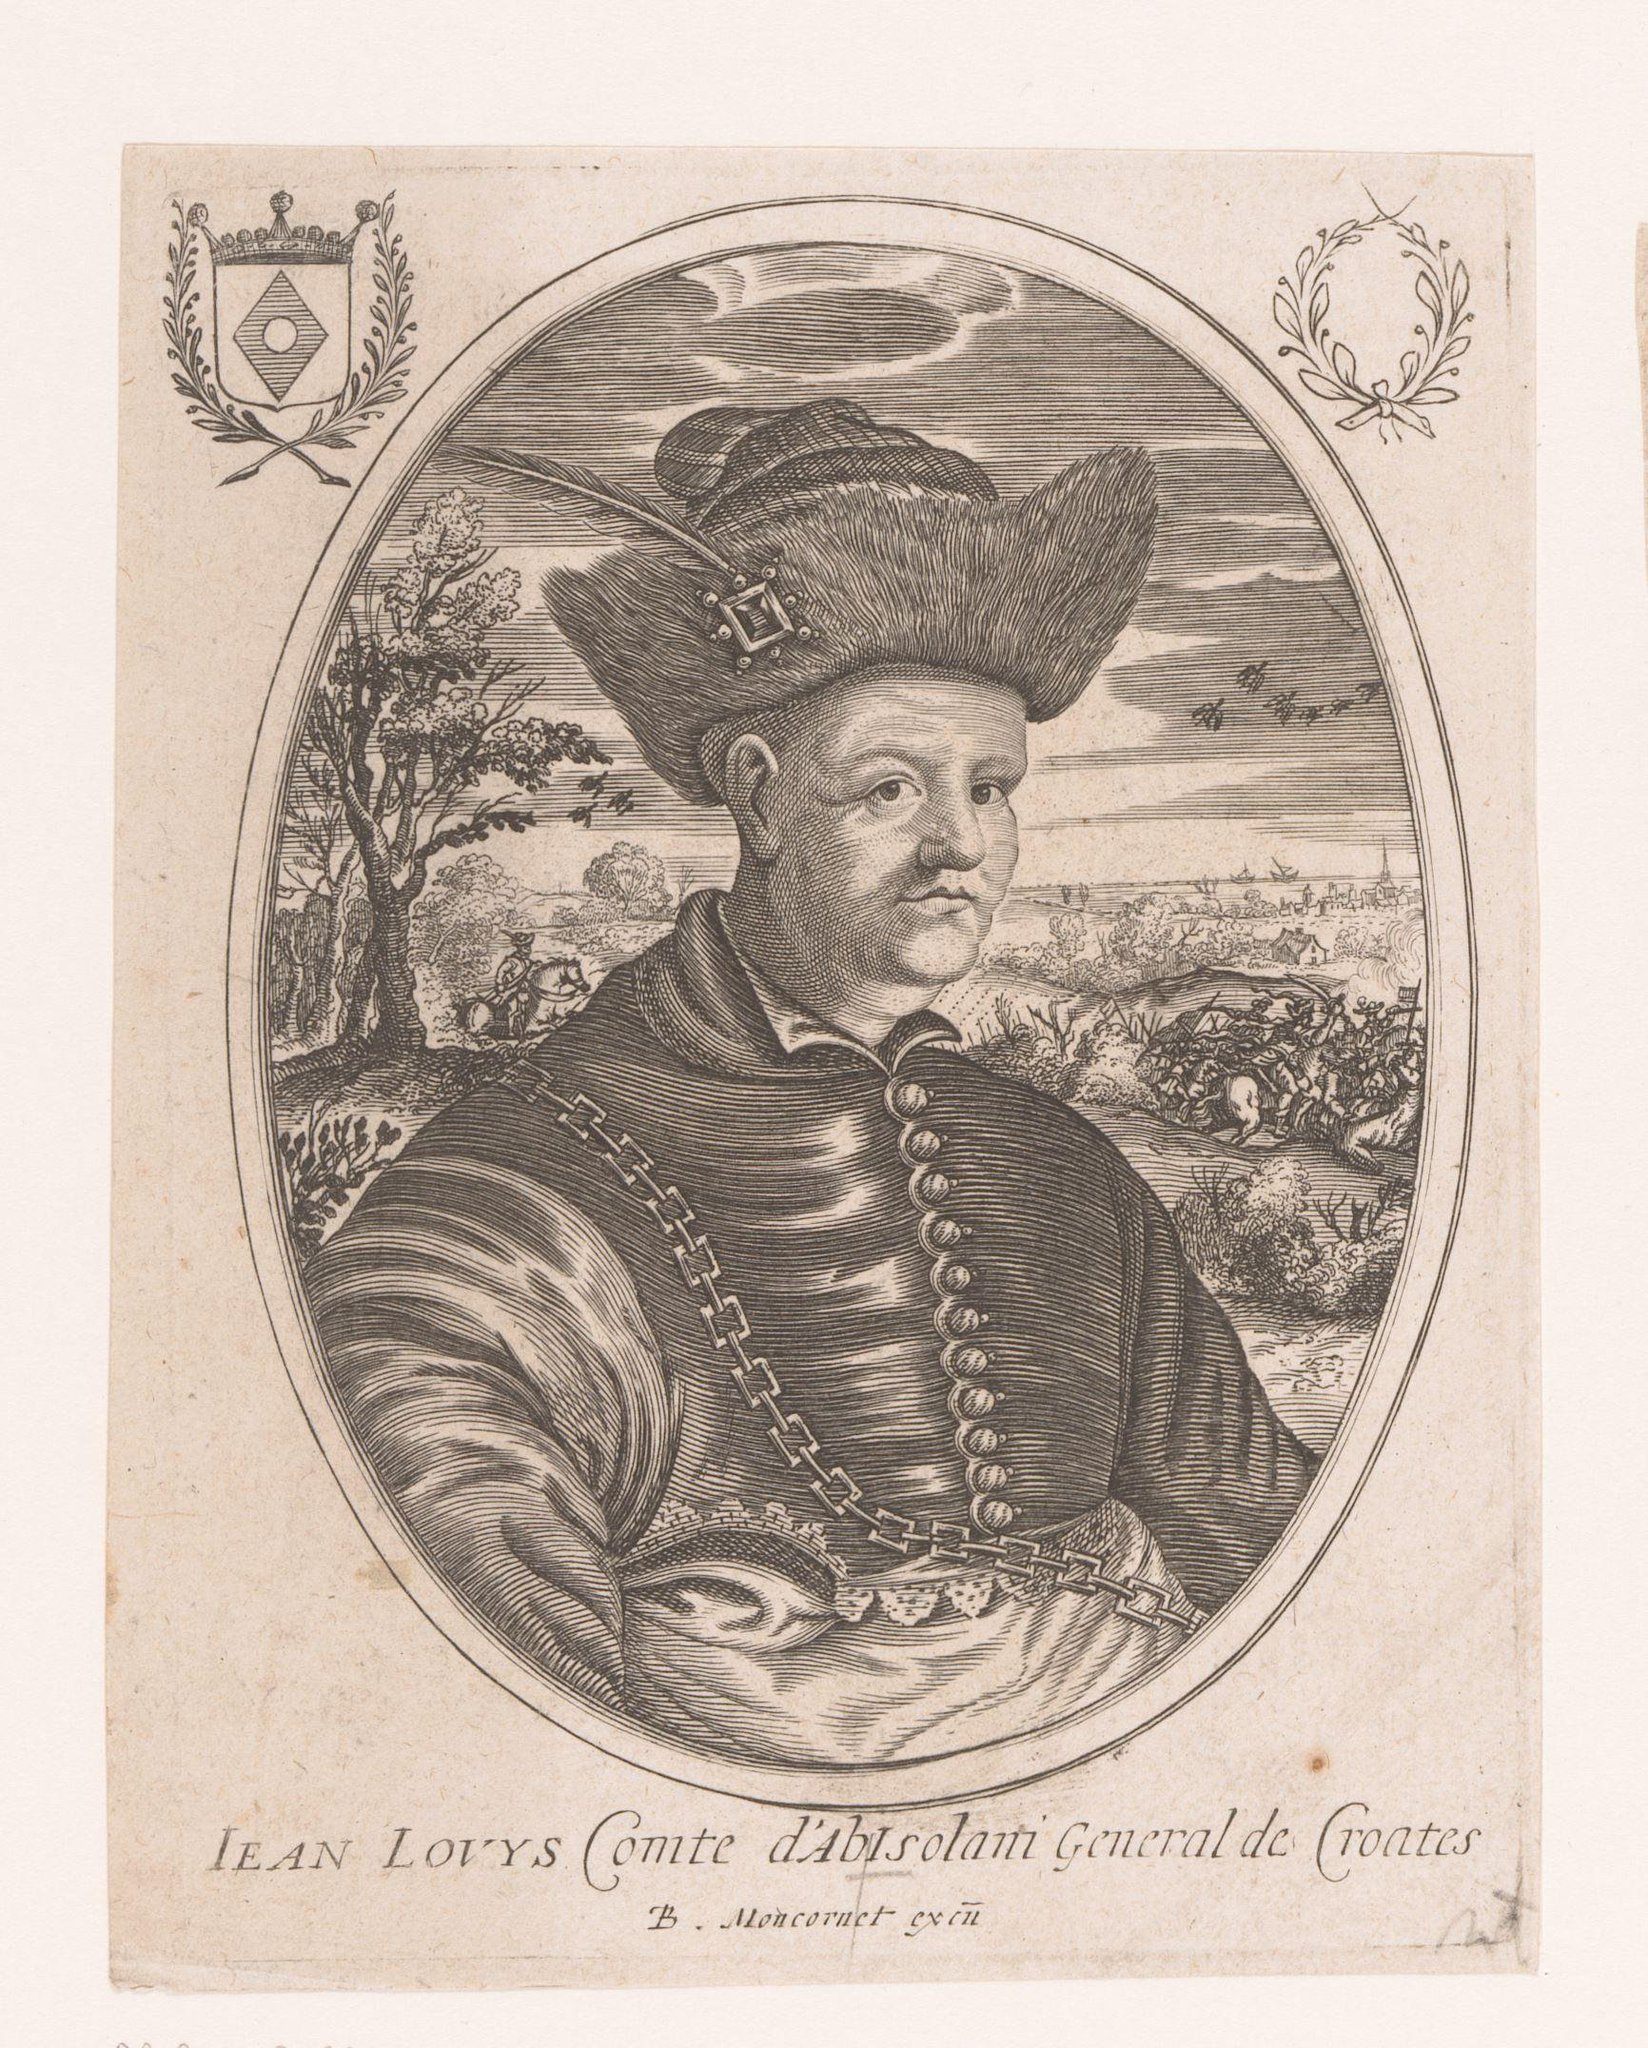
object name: print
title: Portret van Jean Louis, graaf van Abisolami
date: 1610-1668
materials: paper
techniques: engraving, etching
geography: paris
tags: historical persons, armorial bearing, heraldry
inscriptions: collector's mark: Lugt 2228